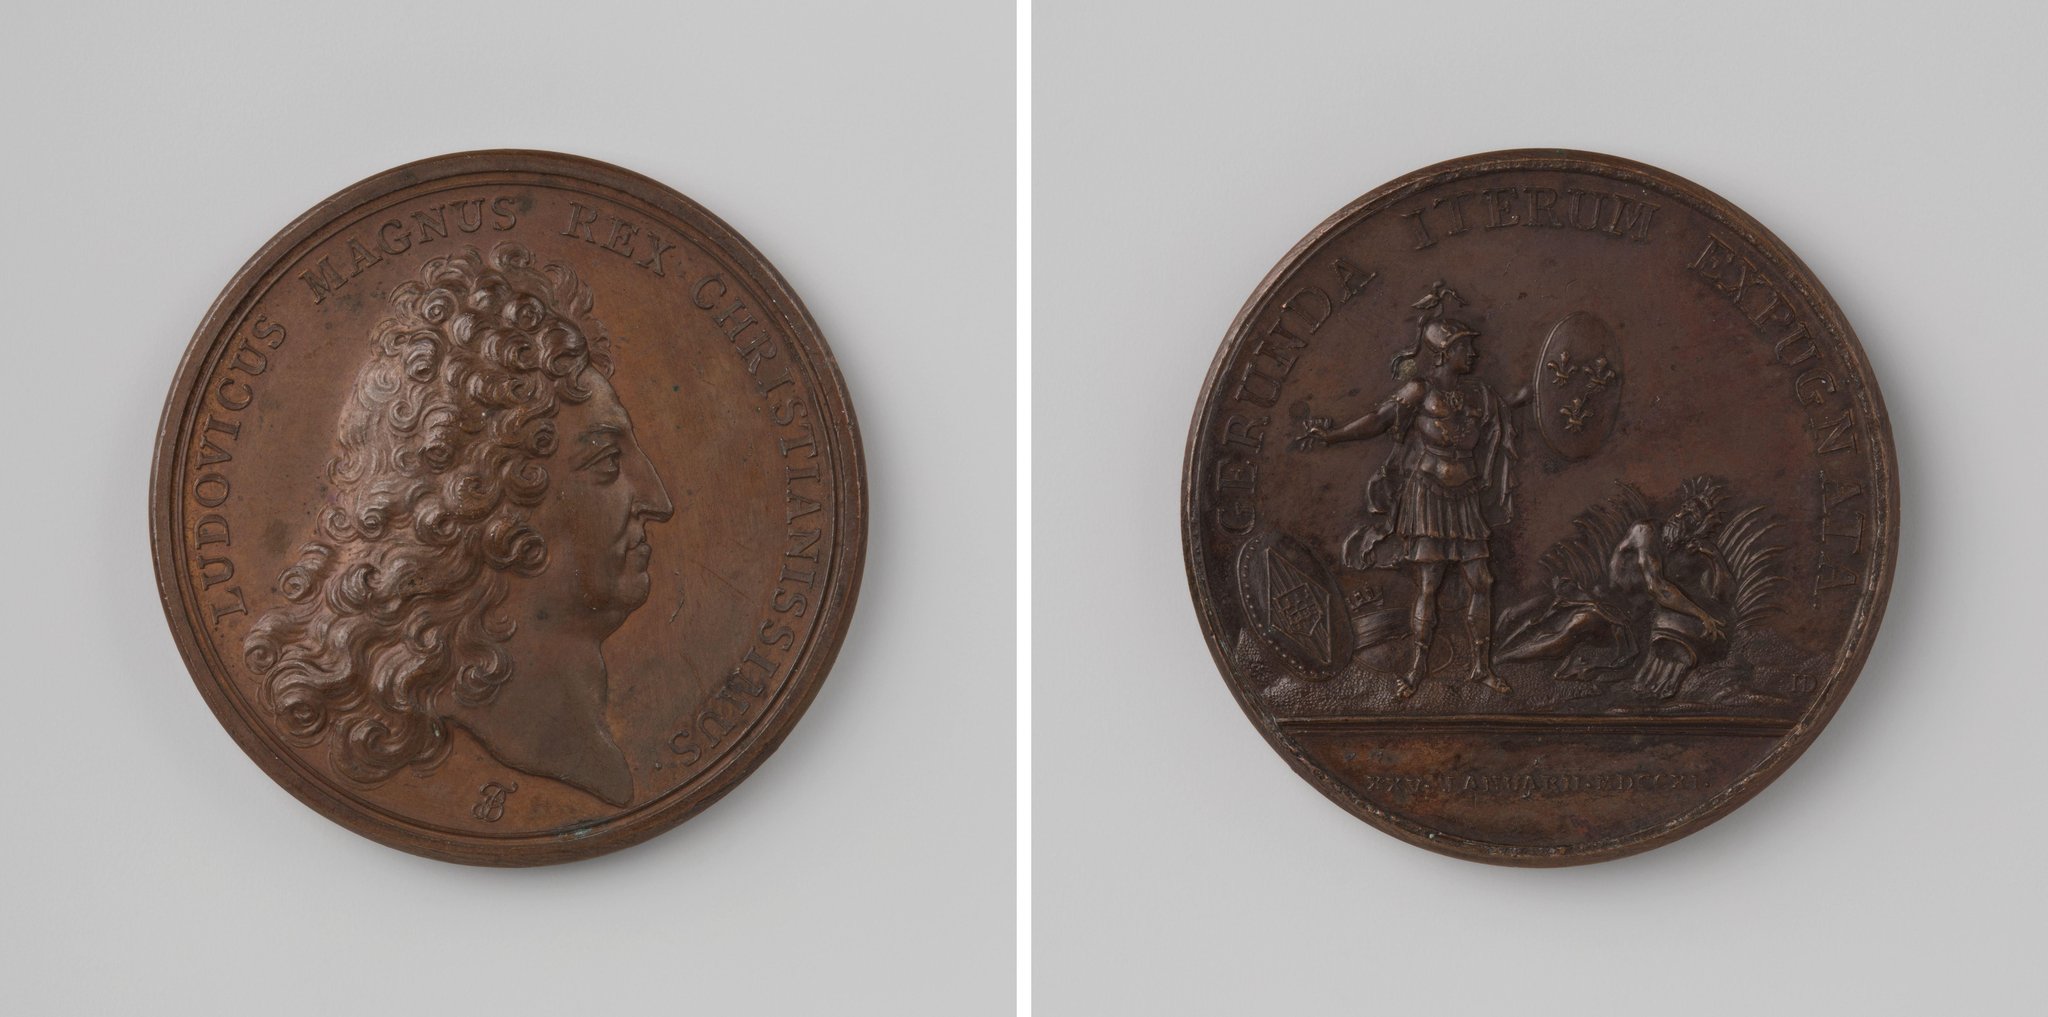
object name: history medal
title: Gerona opnieuw door de Fransen ingenomen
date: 1711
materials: bronze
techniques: striking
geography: paris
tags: lodewijk xiv (koning van frankrijk)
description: Bronzen penning. Voorzijde: borststuk man binnen omschrift. Keerzijde: Frankrijk in gedaante van oorlogsgod Mars staat naast wapenschild van overwonnen stad met in ene hand kroon en in andere wapenschild met lelies, dat hij laat zien aan riviergod die op waterkruik leunt binnen omschrift; afsnede: opschrift.